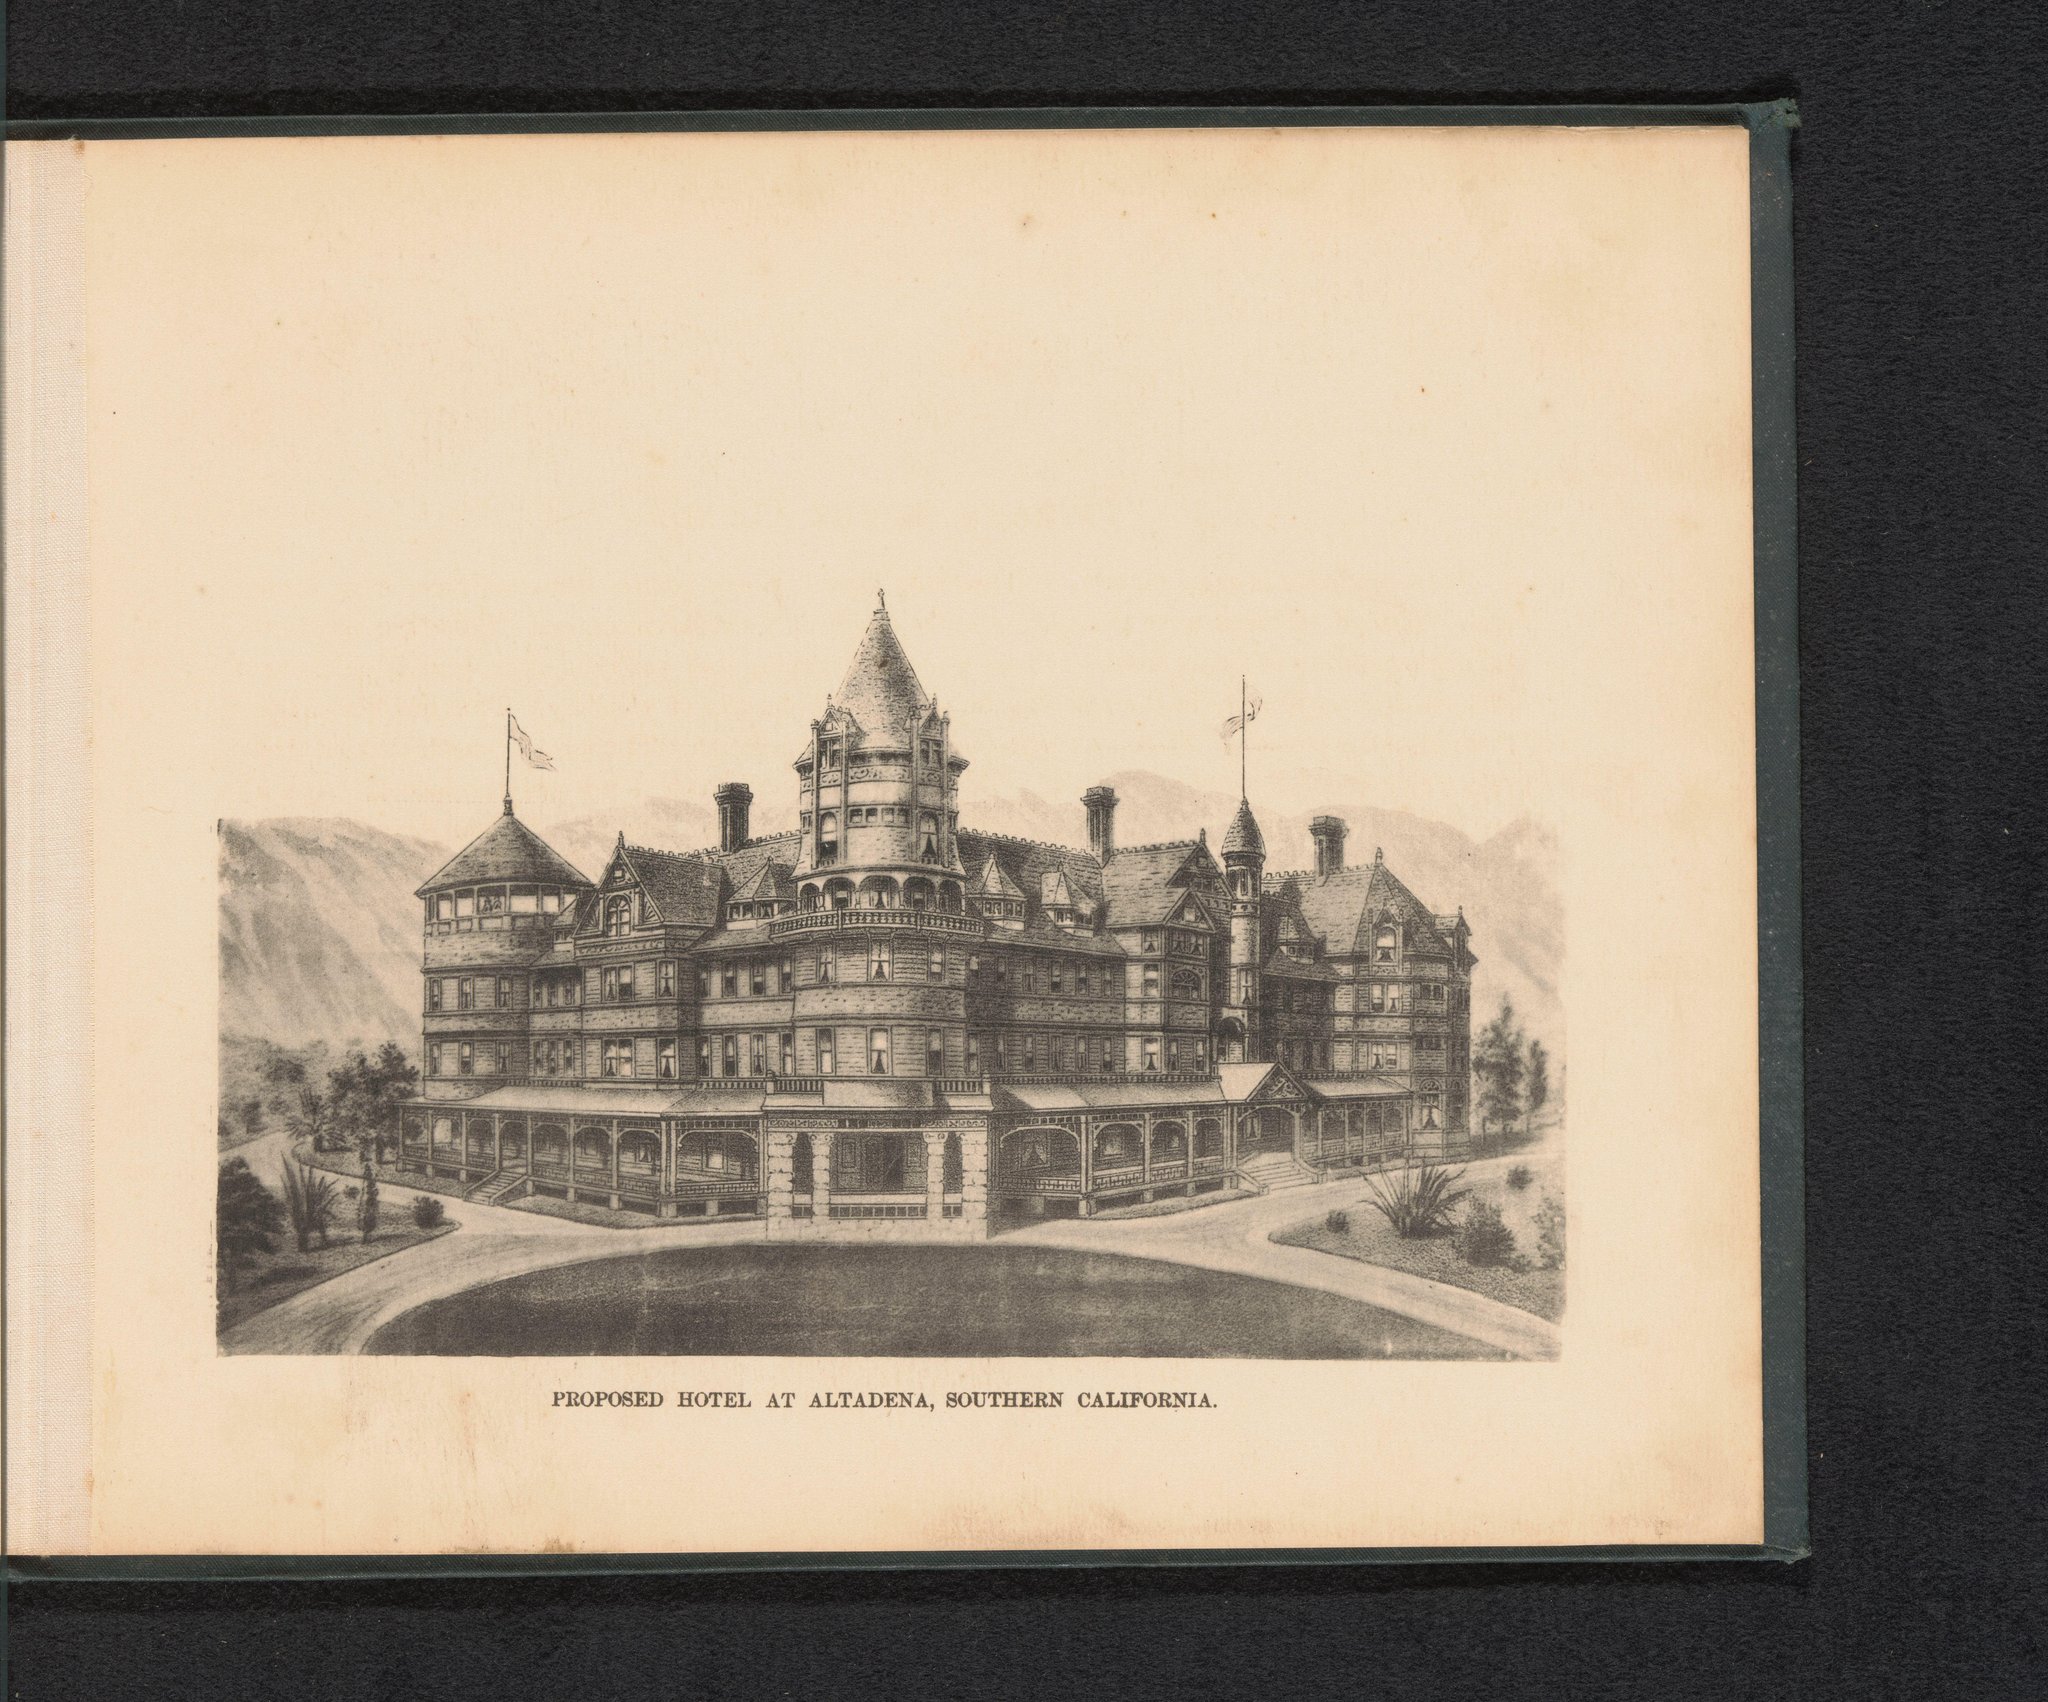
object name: photomechanical print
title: Fotoreproductie van een ontwerptekening voor een nog te realiseren hotel in Altadena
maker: Anonymous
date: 1879-1889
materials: paper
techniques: photograph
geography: united states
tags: hotel, hostelry, inn